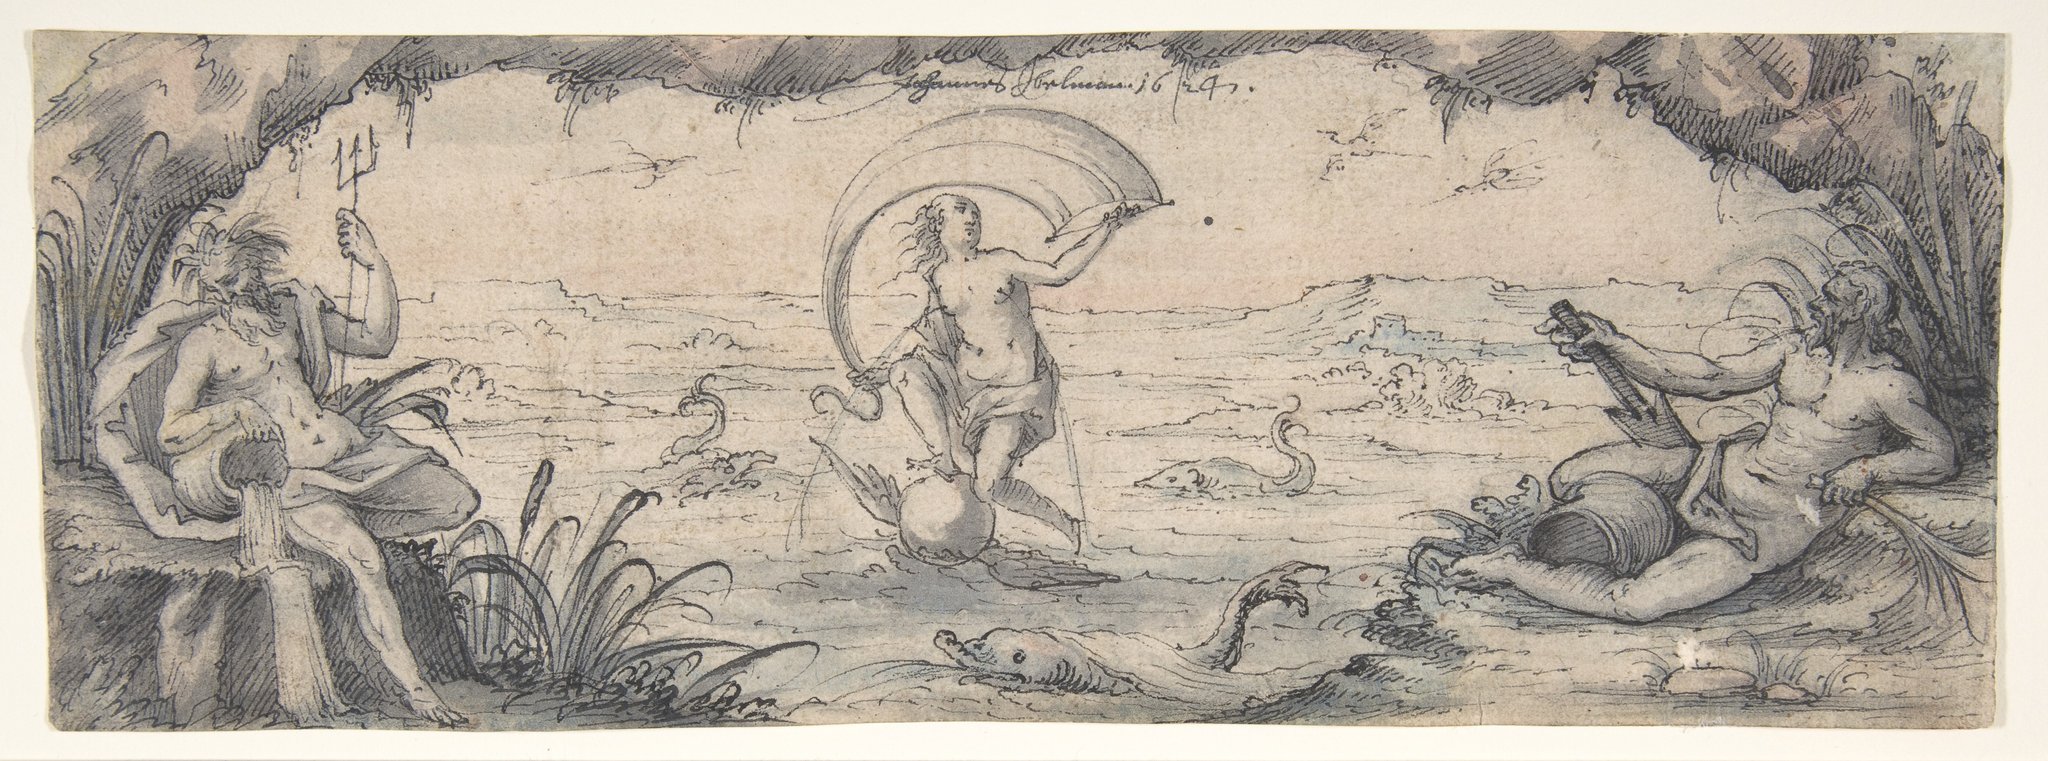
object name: drawing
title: An Allegory of Fortune with Two River Gods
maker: hans jakob ebelmann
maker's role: artist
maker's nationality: german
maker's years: 1570-1625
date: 1624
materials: chalk, ink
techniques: pen, wash